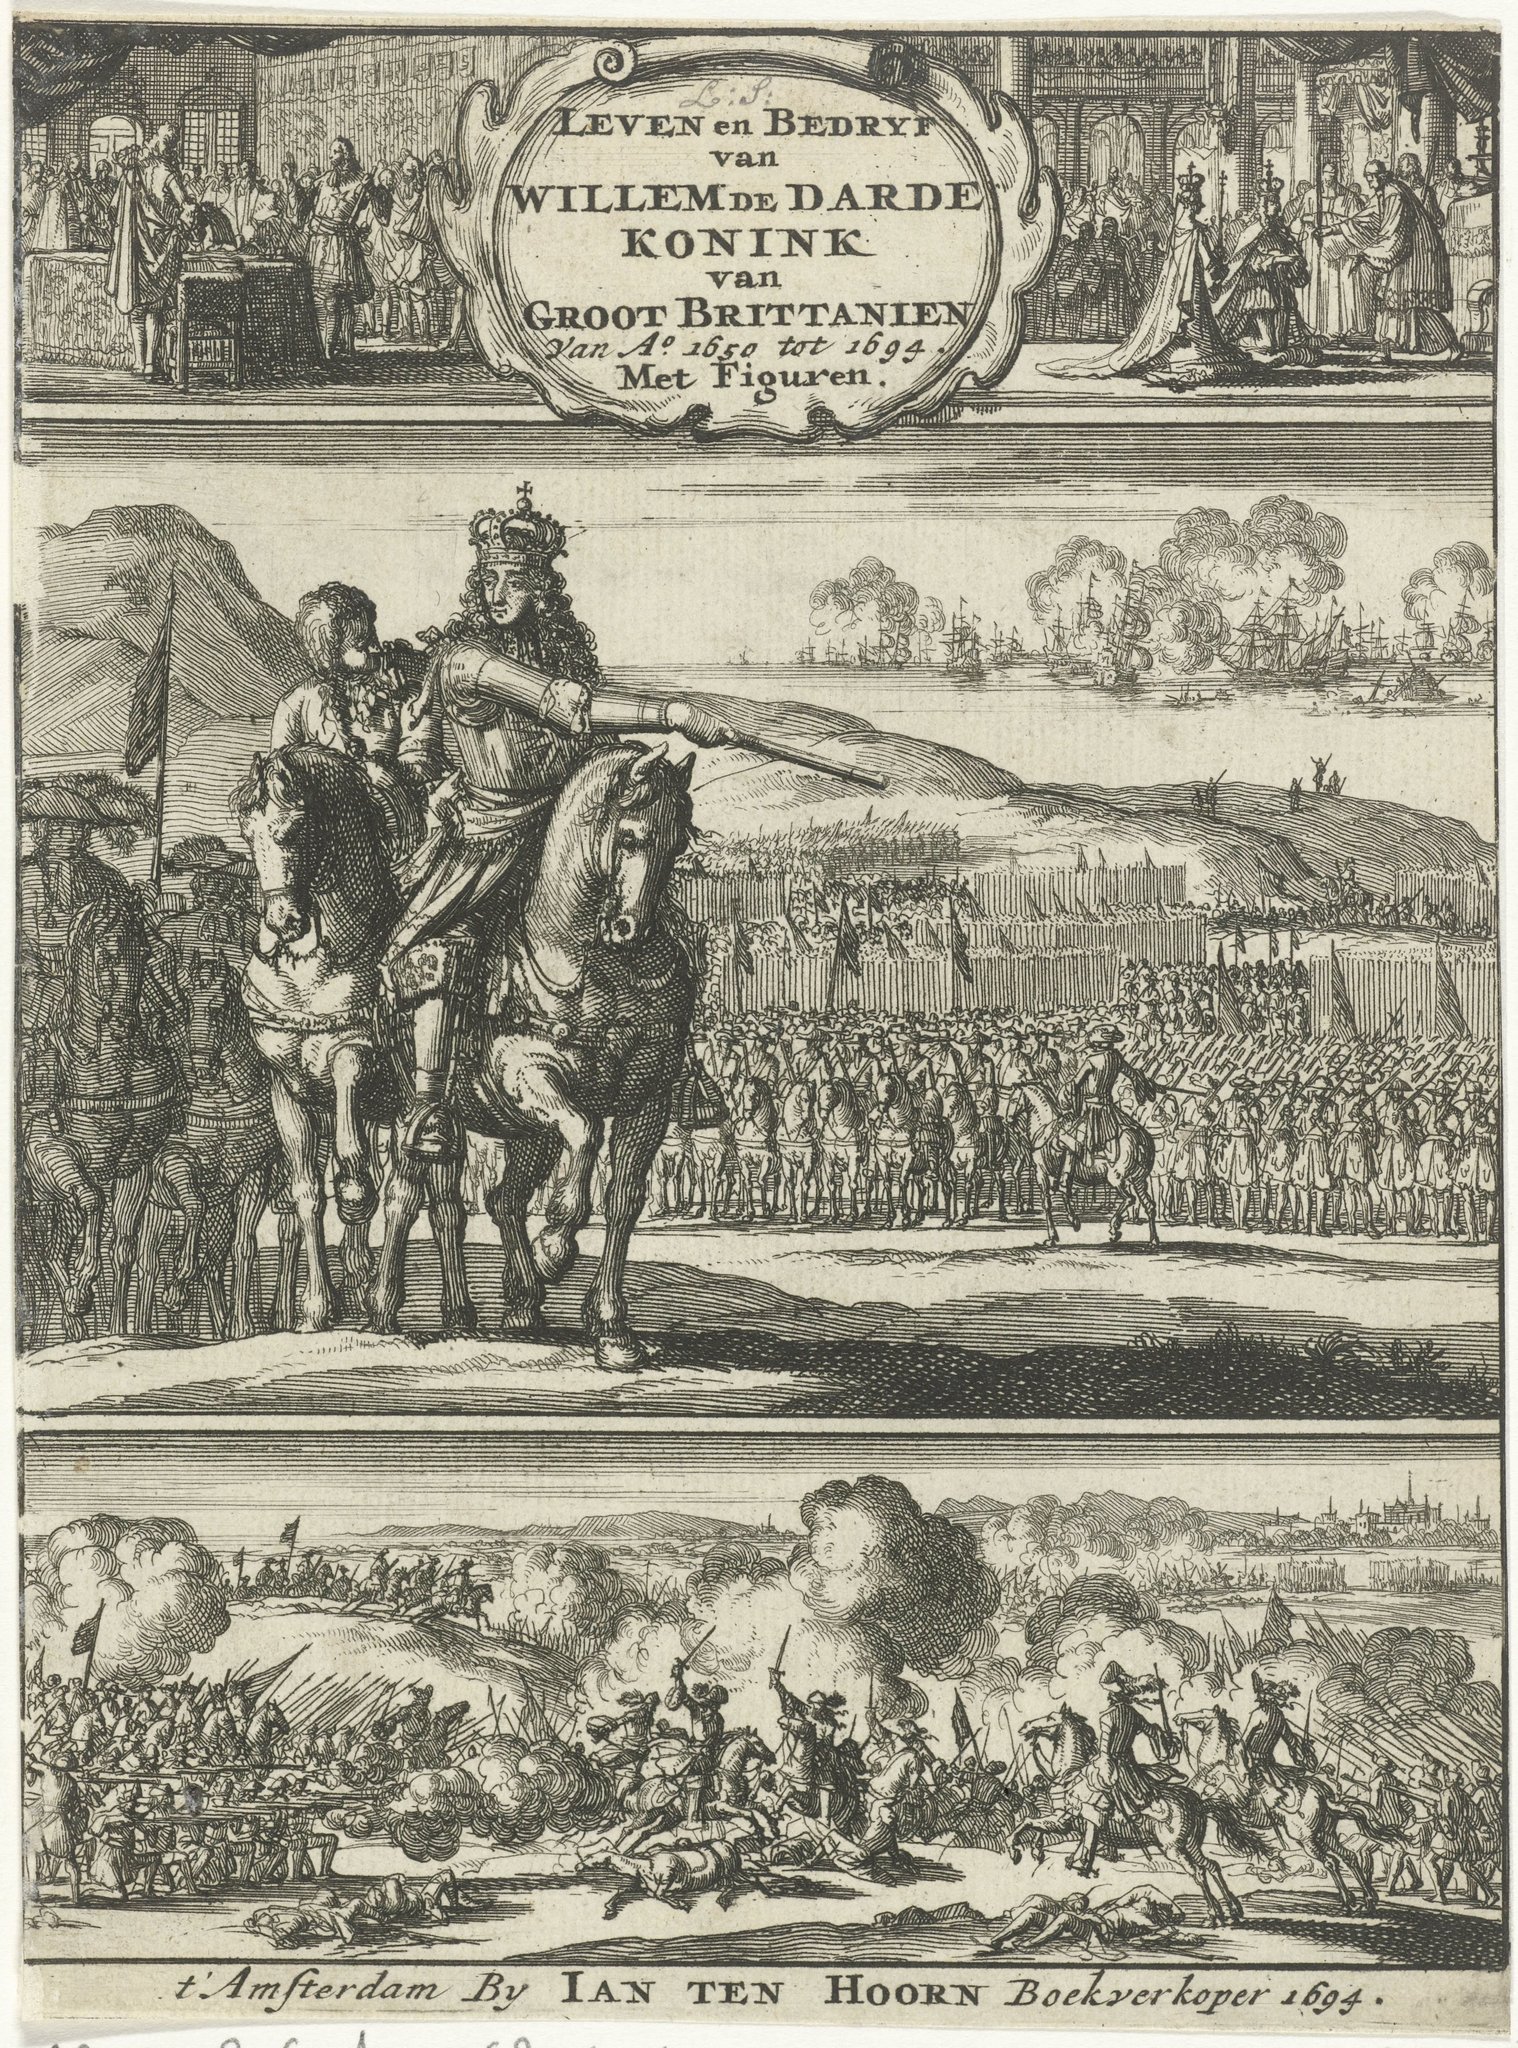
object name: print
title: Titelpagina voor: L. van den Bos, Het leven en bedryf van Willem de Darde, 1694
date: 1694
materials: paper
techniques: etching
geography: amsterdam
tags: the hague, william iii (prince of orange and king of england, scotland, and ireland), battle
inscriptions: collector's mark: Lugt 2228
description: Vier scènes uit het leven van Willem III, prins van Oranje-Nassau, koning van Engeland. Hoofdvoorstelling: Willem III als bevelhebber tijdens een veldslag. Boven: Benoeming van Willem III tot stadhouder; Kroning van Willem III en Maria II Stuart in de Westminster Abbey. Onder: Hevige veldslag.